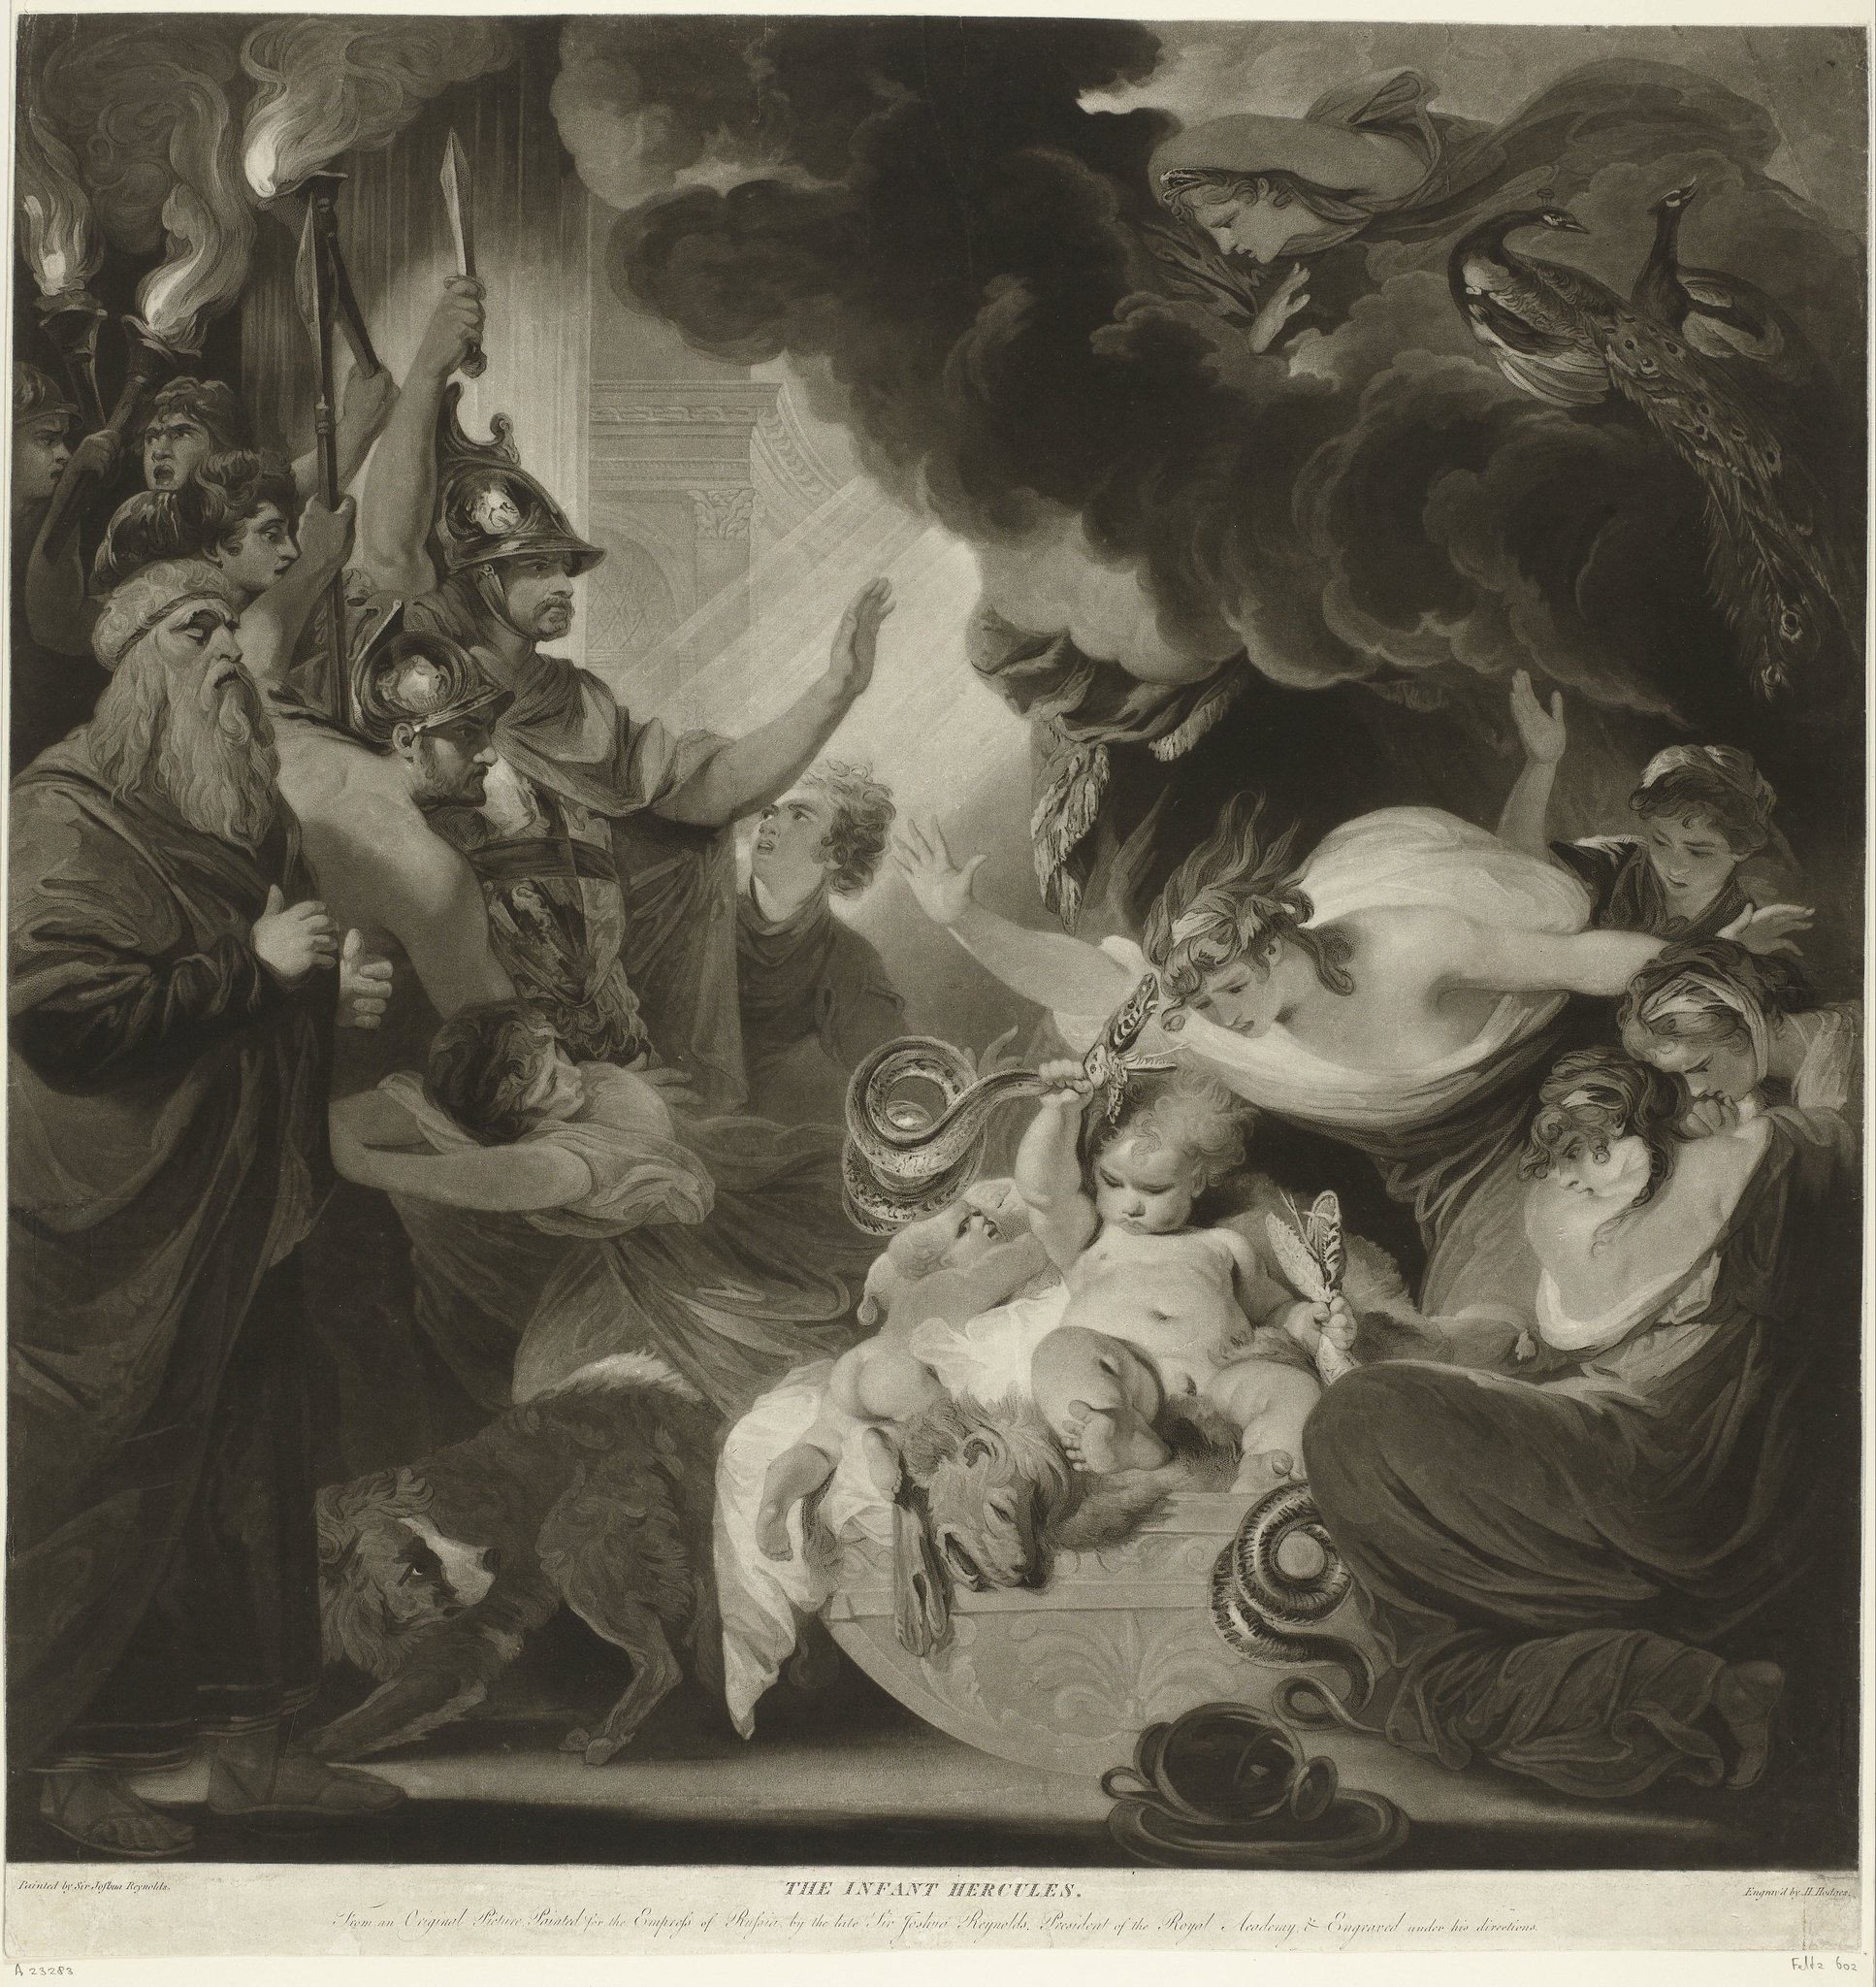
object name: print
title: Hercules wurgt in zijn wieg de twee slangen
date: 1793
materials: paper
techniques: mezzotint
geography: england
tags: hercules strangles two serpents in his cradle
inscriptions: collector's mark: Lugt 2228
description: Hercules ligt in zijn wieg en wurgt met zijn blote handen twee slangen. Juno, die de slangen stuurde, slaat het wonder gade vanaf een wolk.